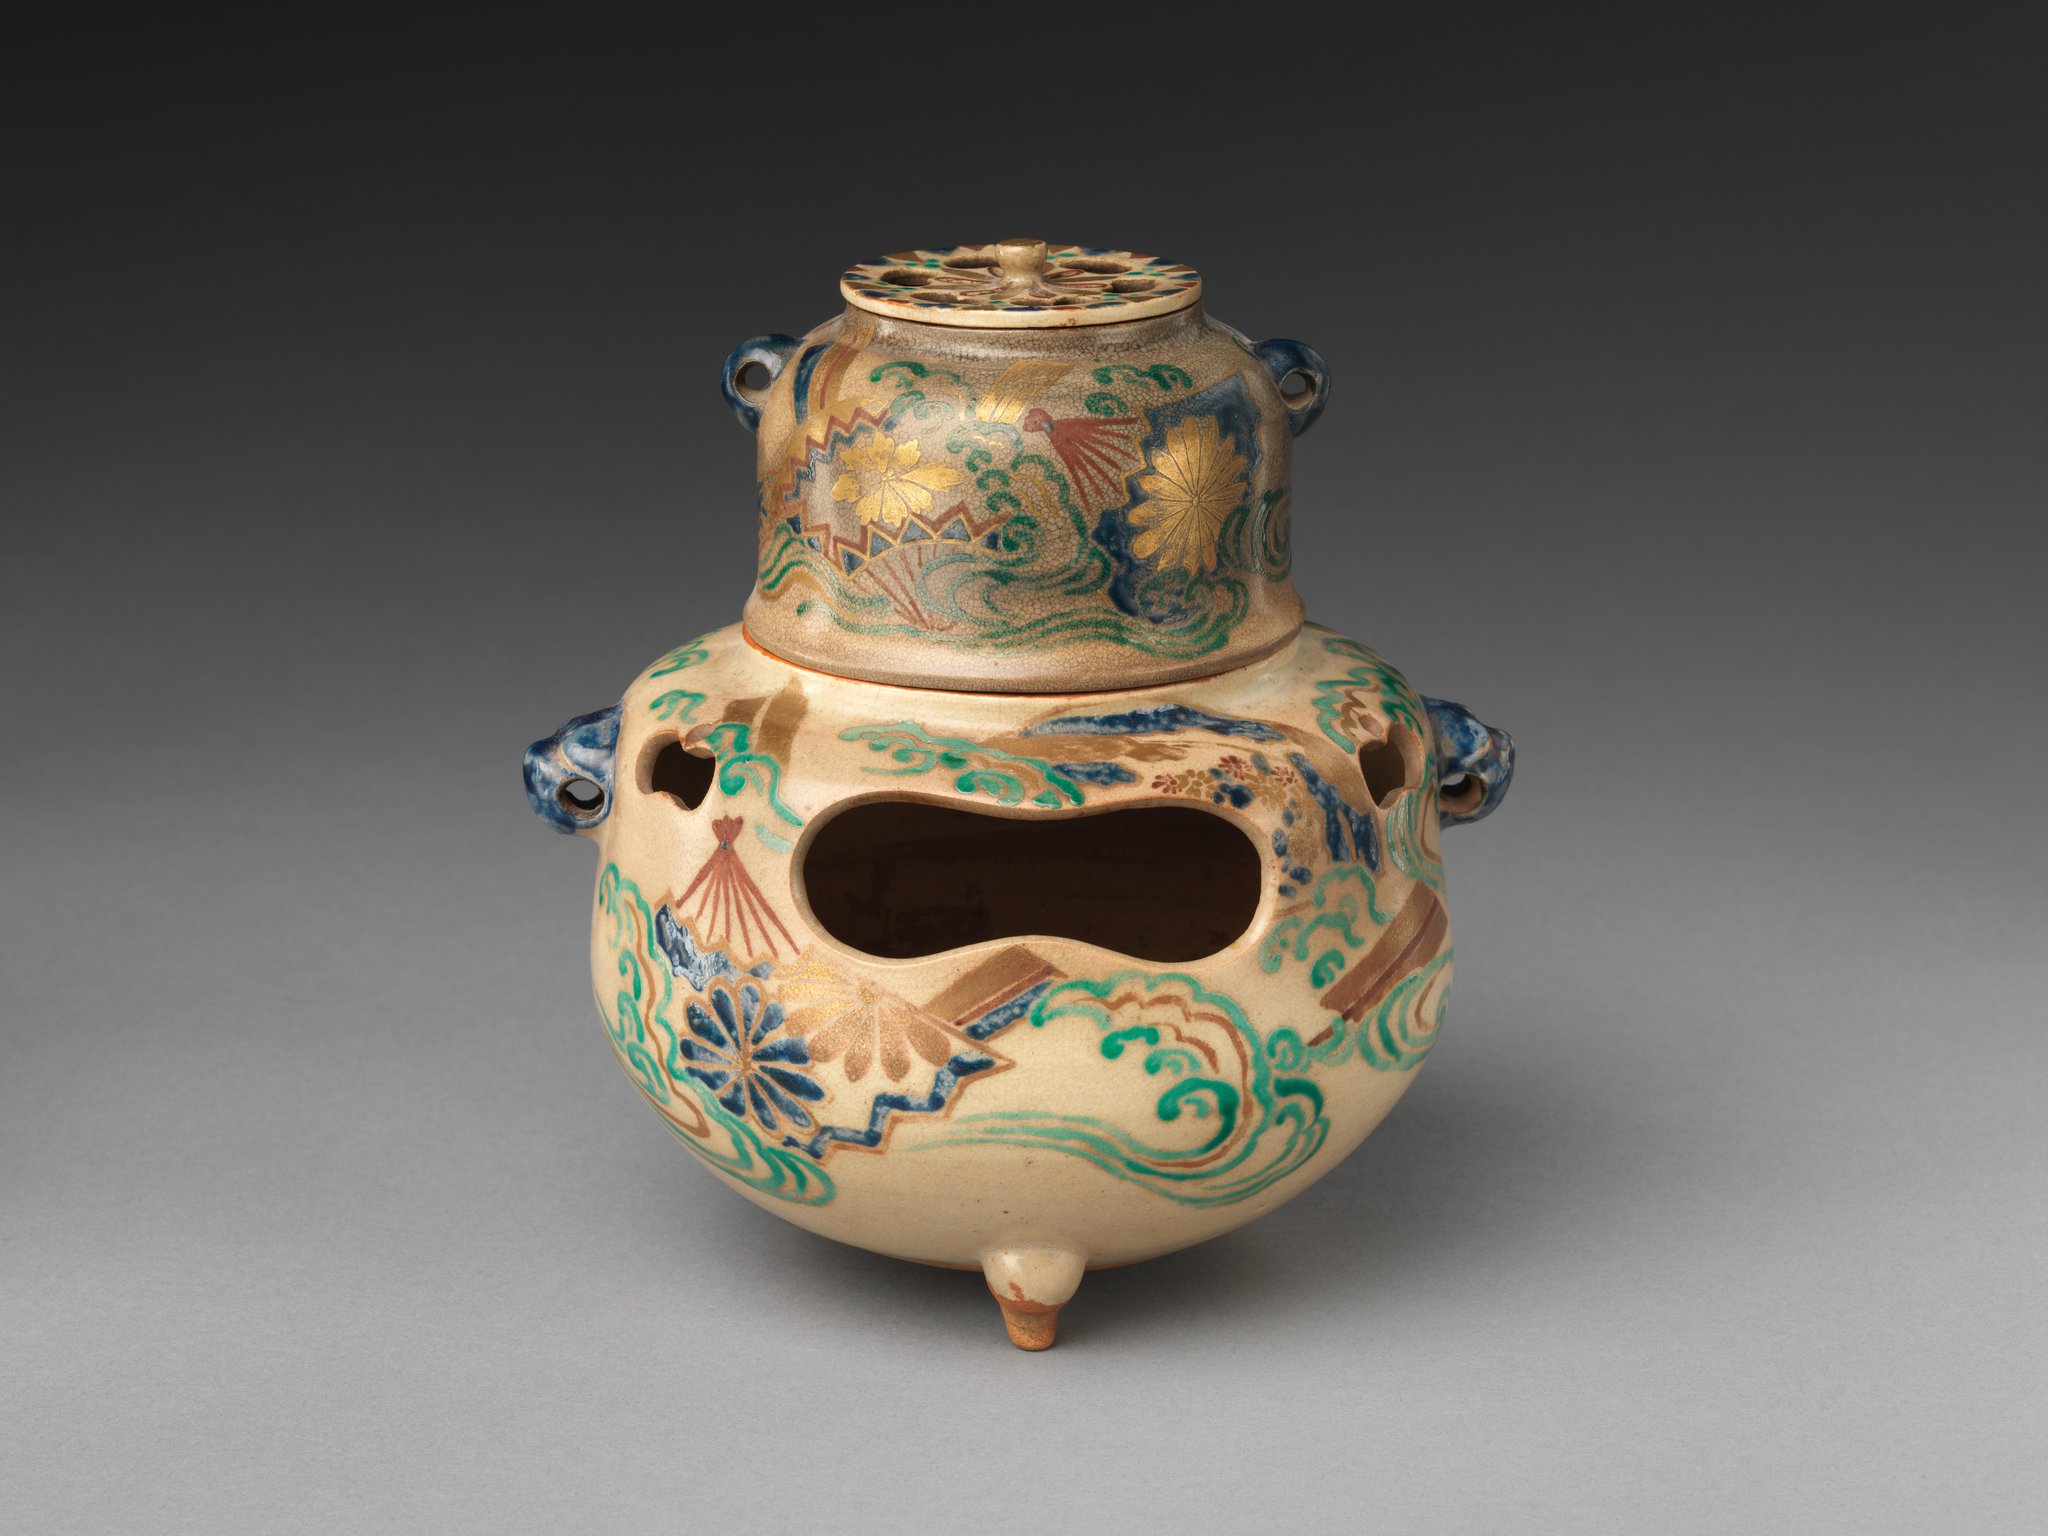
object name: clove boiler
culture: japanese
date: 1701-1800